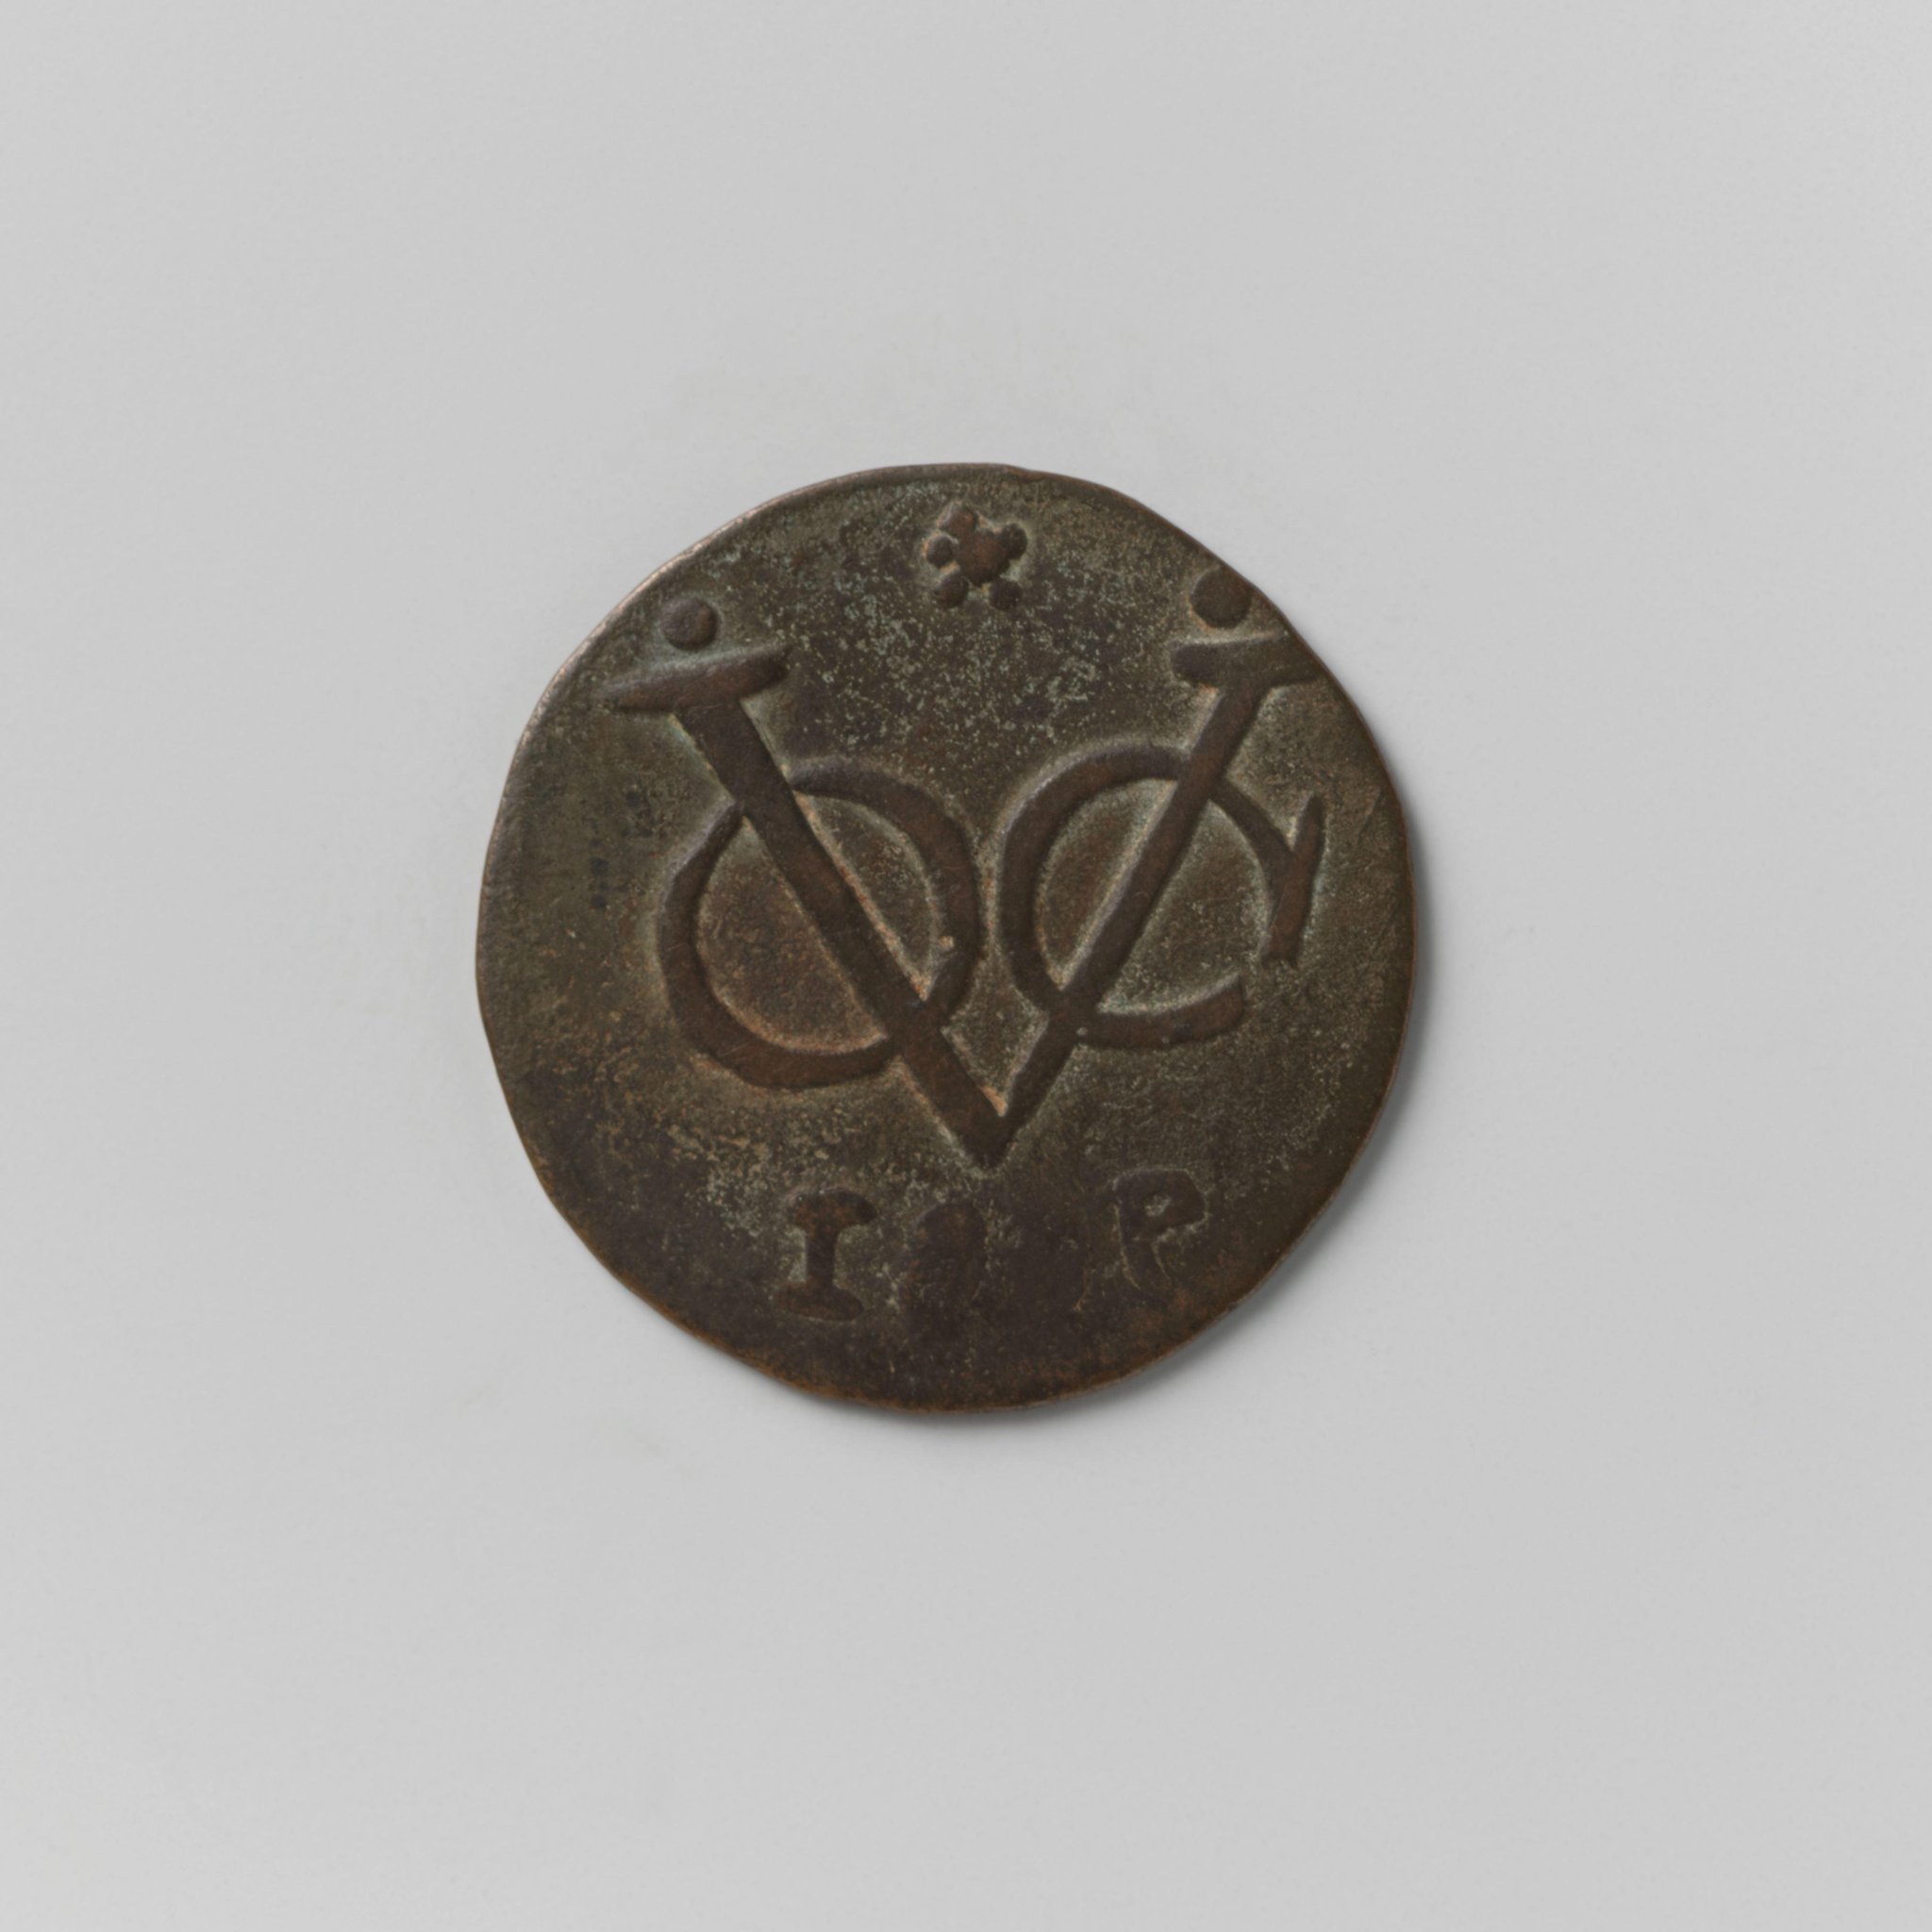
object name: coin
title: Nabootsing van VOC- duit West-Friesland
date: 1780-1830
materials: copper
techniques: striking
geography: banjarmasin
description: Koperen munt. Nabootsing van duit van de VOC uit West-Friesland. Voorzijde: gekroond wapenschild van West-Friesland. Keerzijde: monogram van de VOC, waarboven muntmeesterteken en waaronder fictief jaartal.